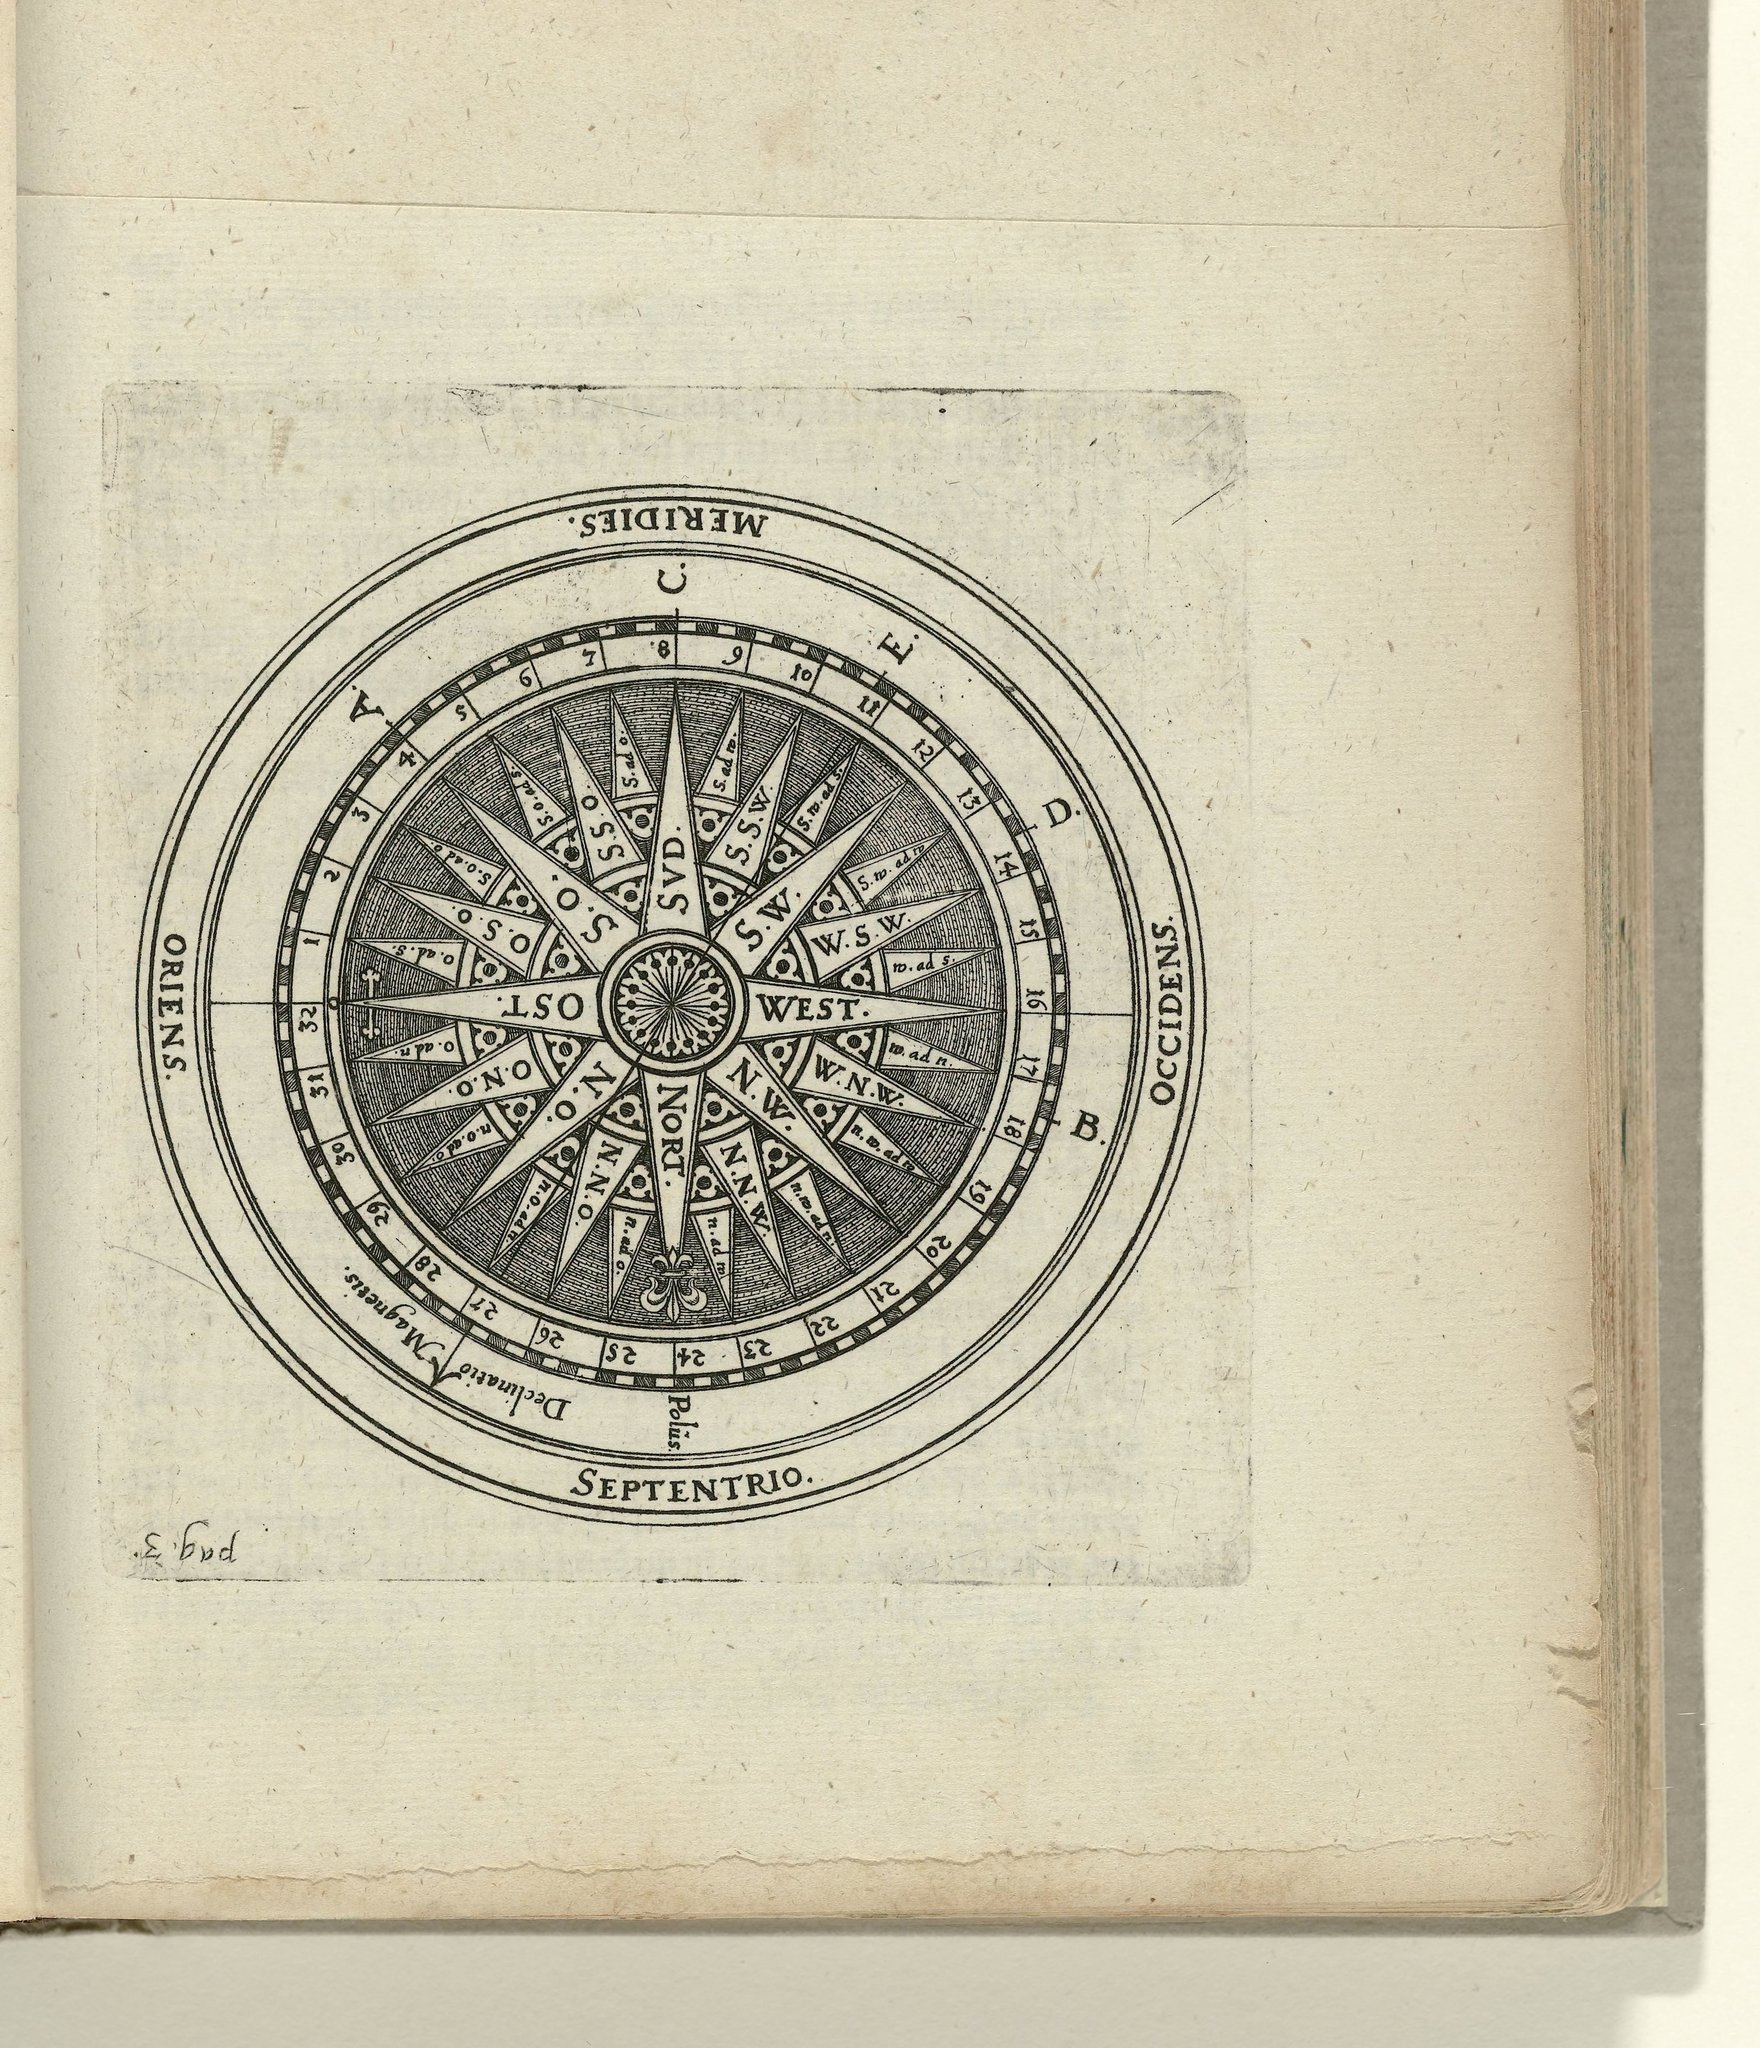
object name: print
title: Windroos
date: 1598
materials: paper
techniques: engraving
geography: nuremberg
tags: willem barendsz., amsterdam, jacob van heemskerck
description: Windroos. Tegenover pagina 3 in: 'Warhafftige Relation. Der dreyen newen unerhörten seltzamen Schiffart so die Holländischen und Seeländischen Schiff....Anno 1594, 1595 und 1596 verricht' (1598).